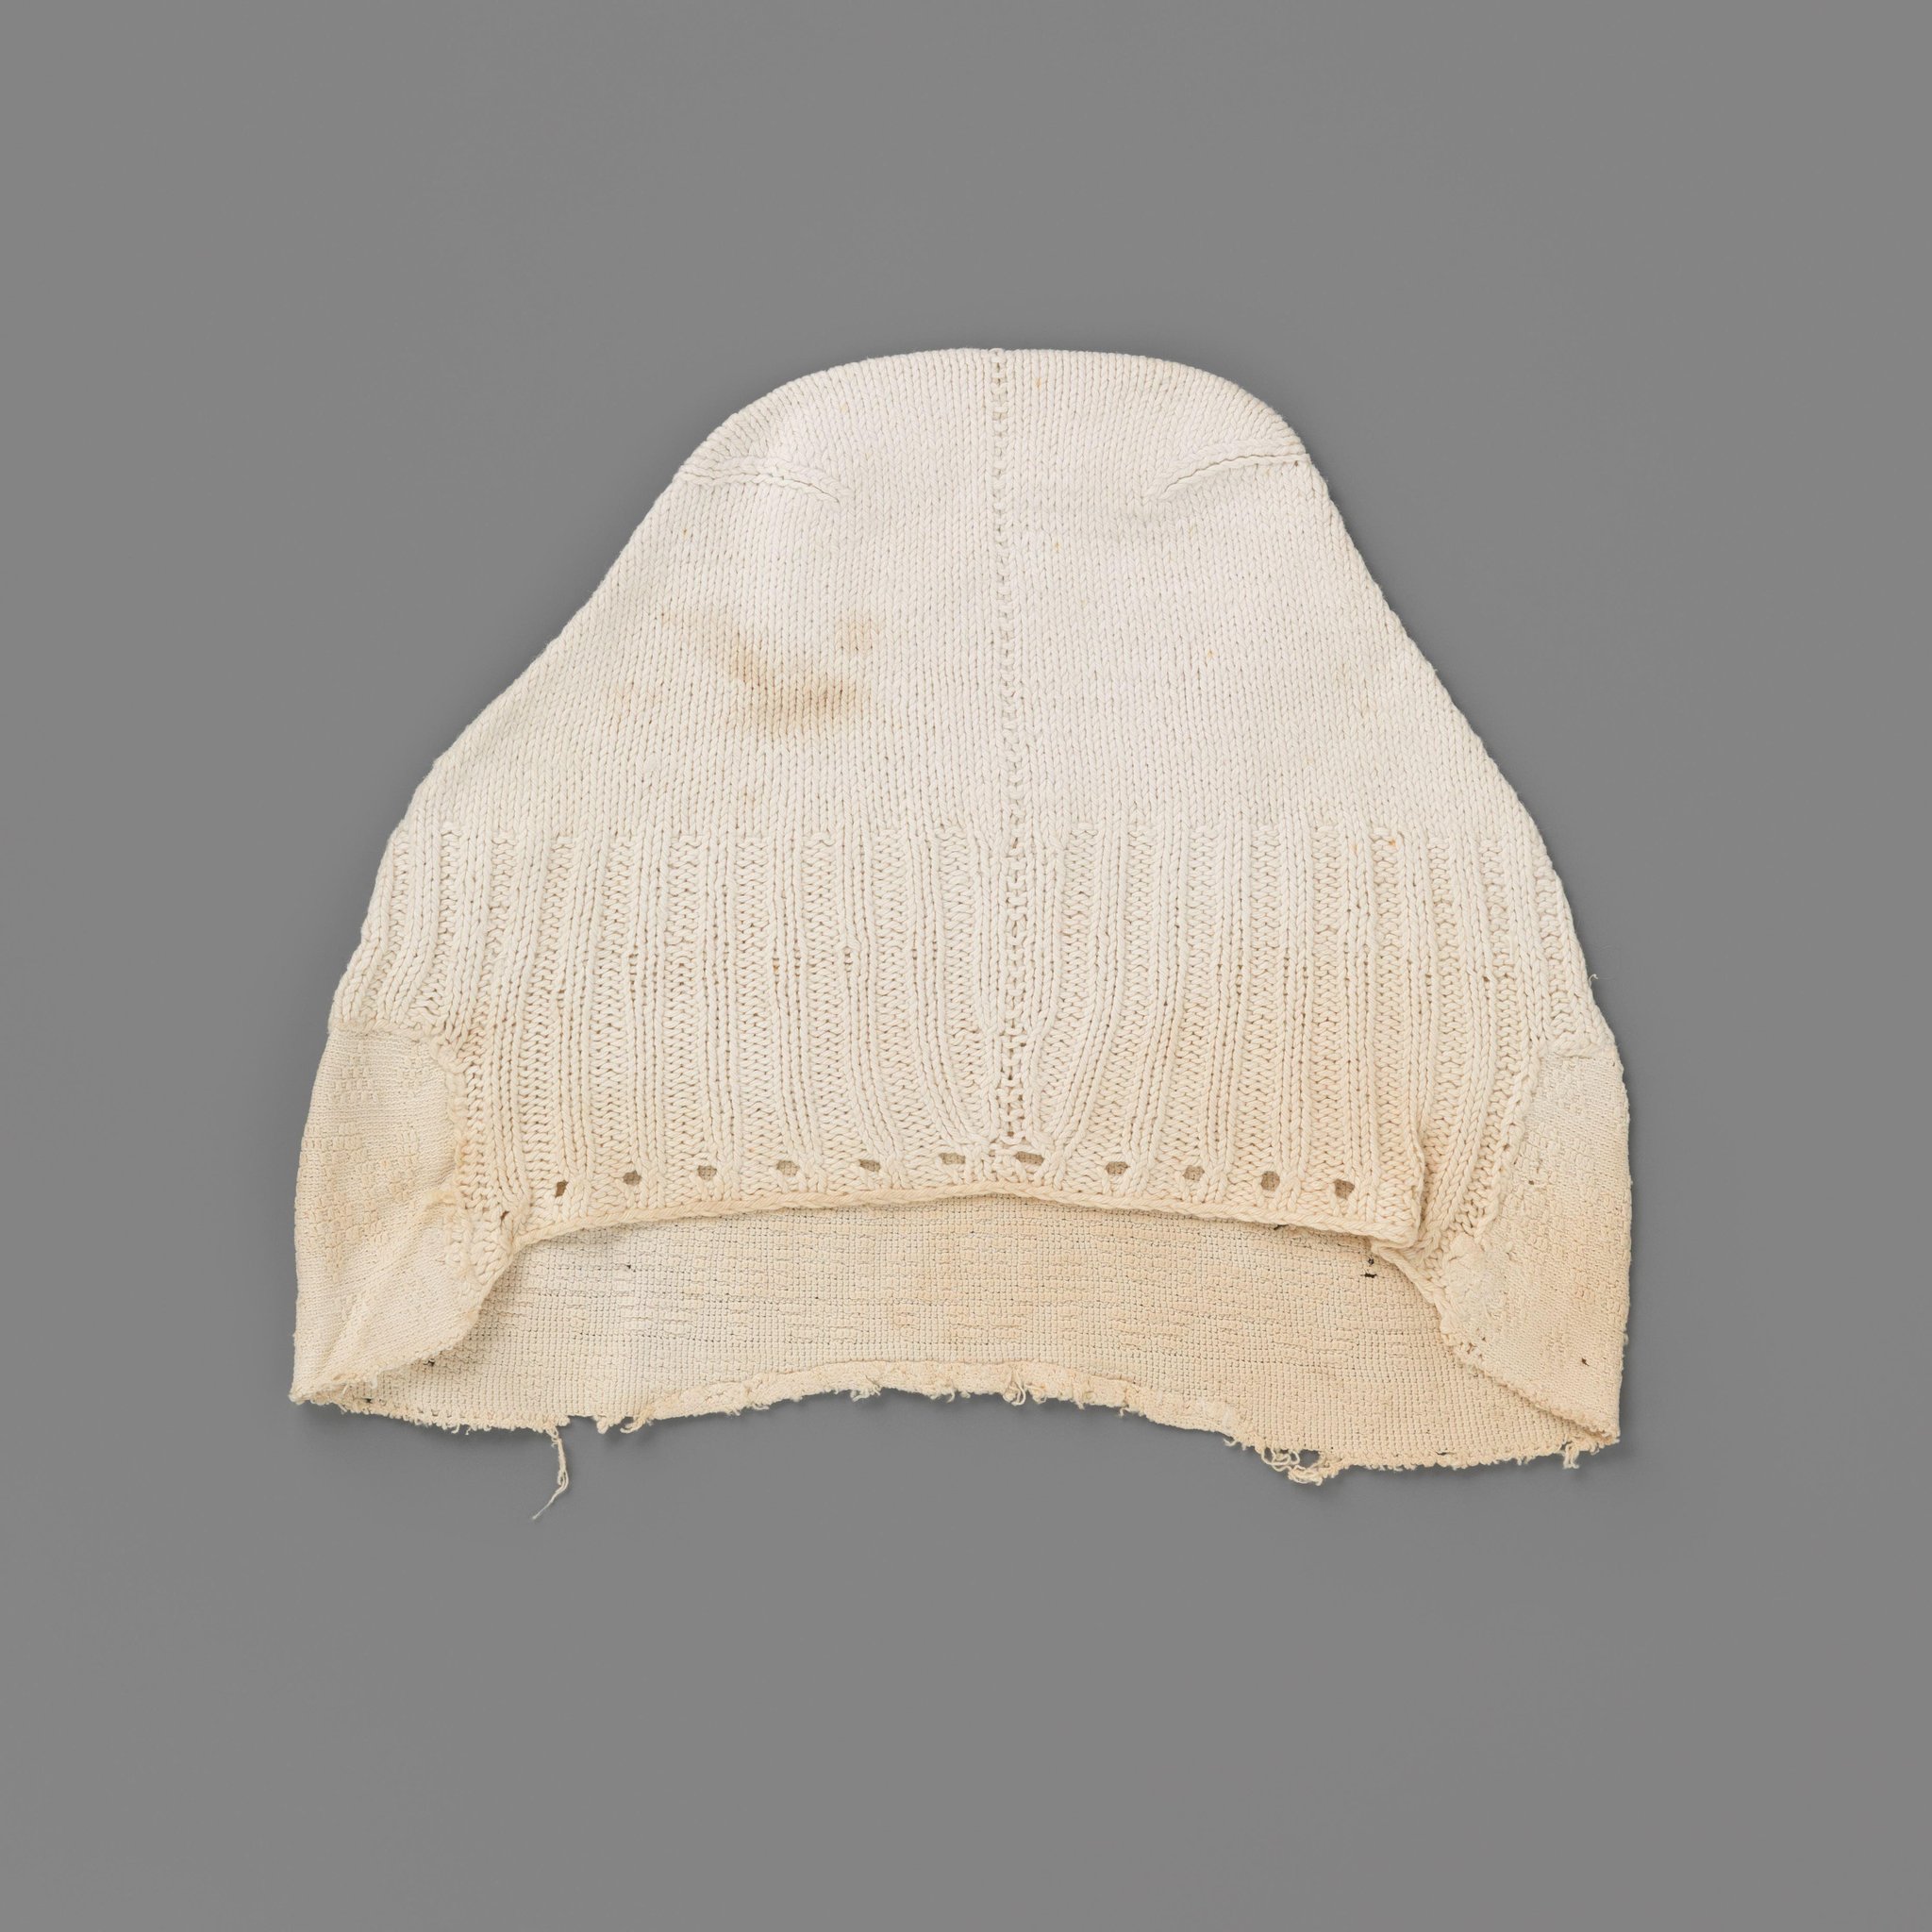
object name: cap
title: Muts voor daagse- of onderdracht van gebreide katoen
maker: Anonymous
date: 1800-1900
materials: cotton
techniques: knitting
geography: friesland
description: Muts van gebreide katoen. De bol is langs het voorhoofd afgezet met een strook met een fijnere struktuur. Voor daagse- of onderdracht.